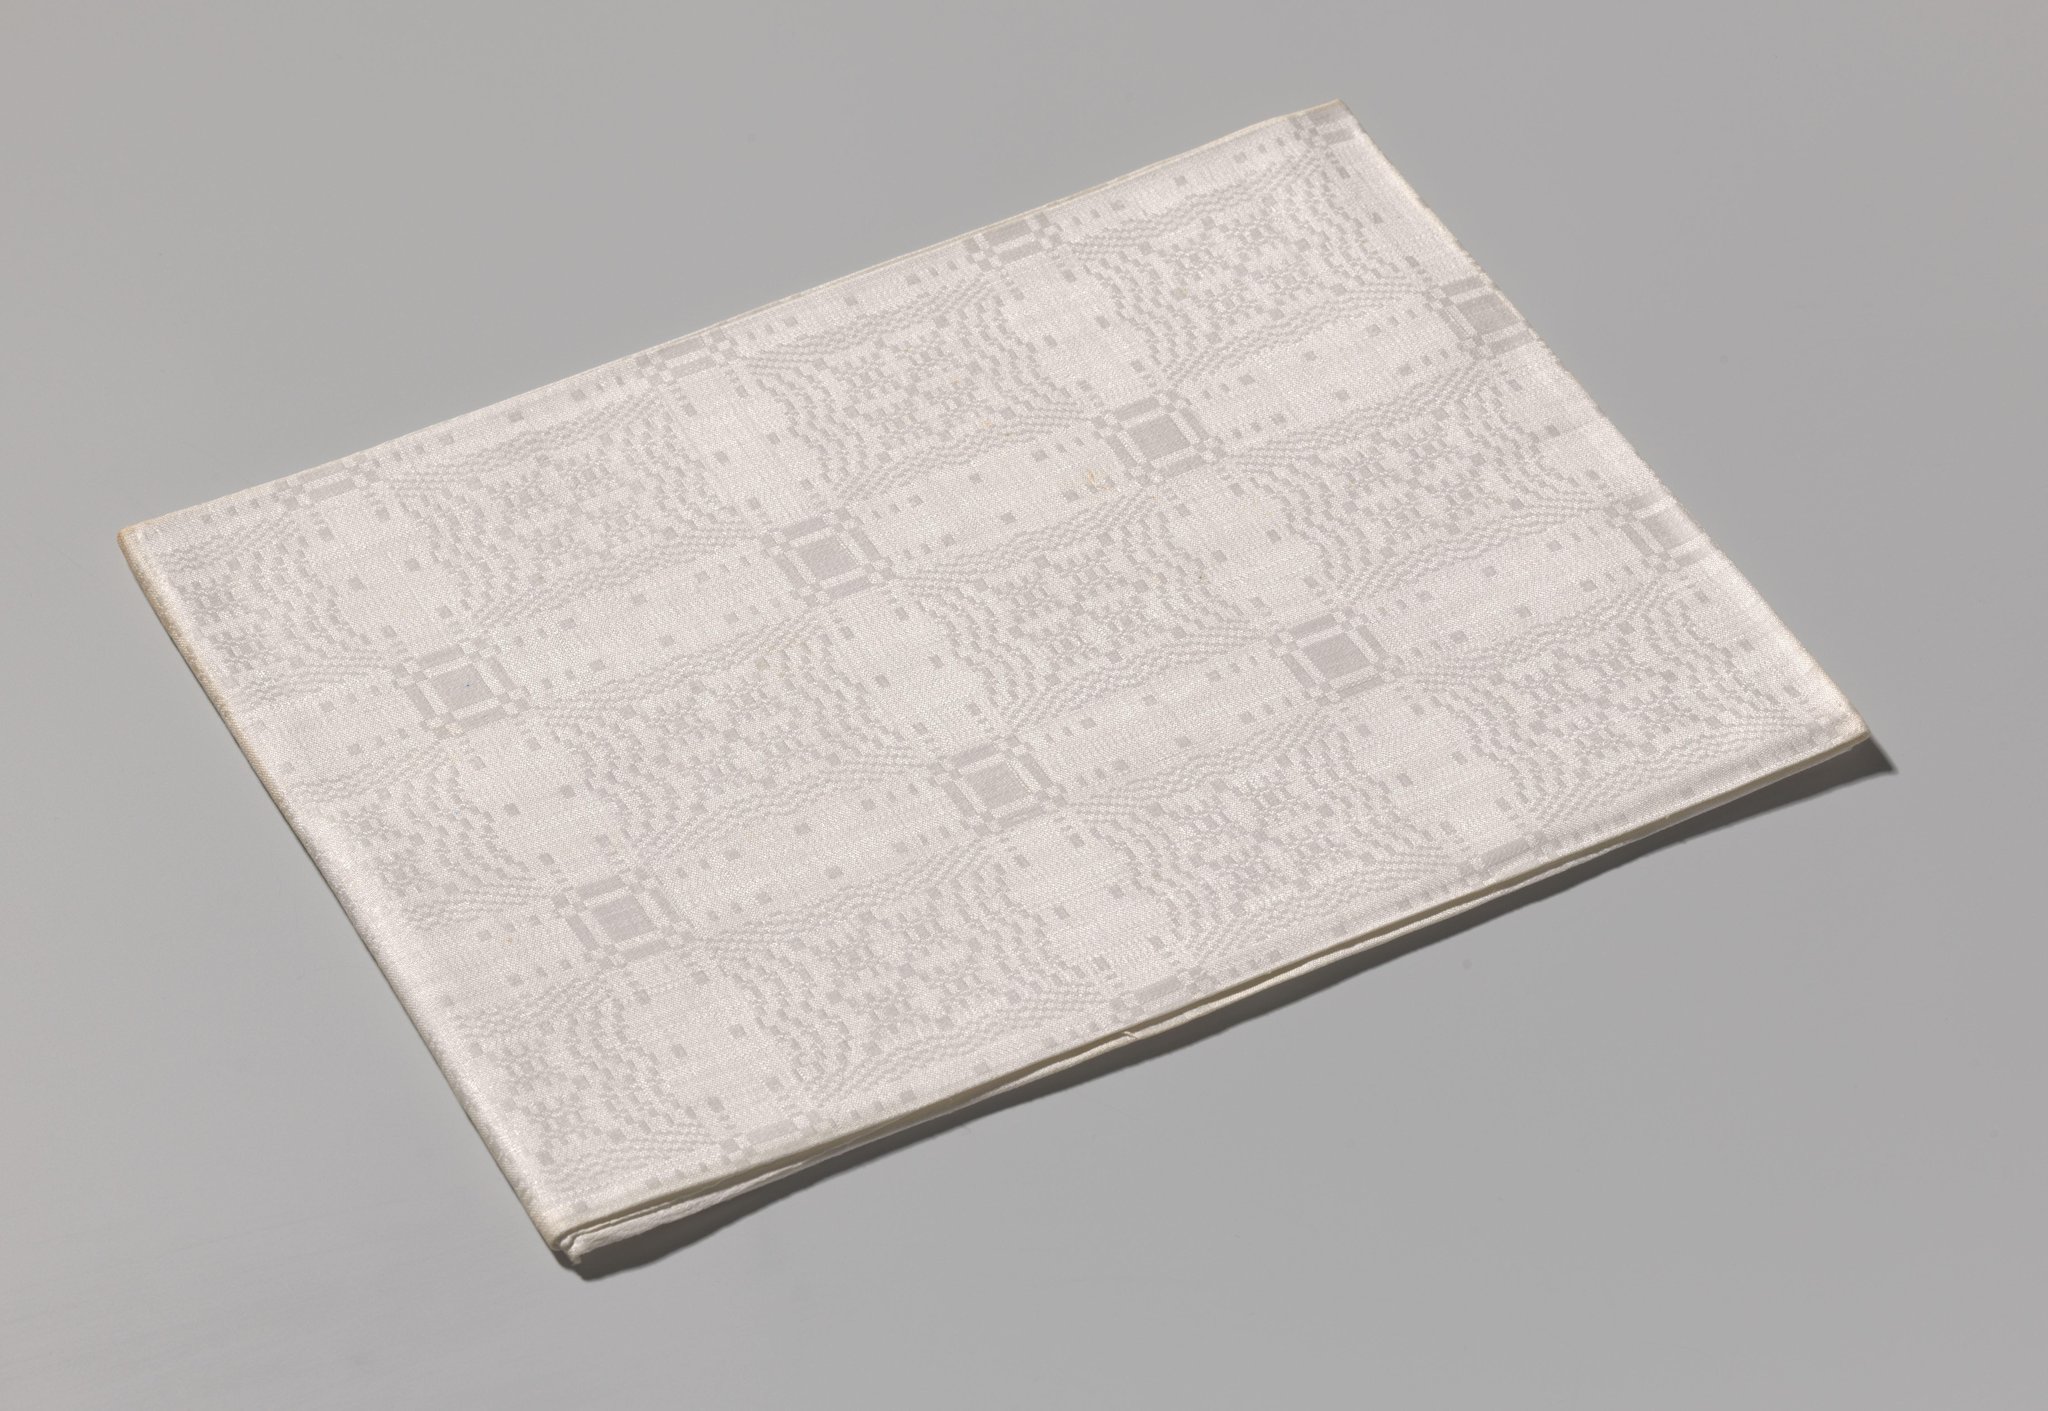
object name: napkin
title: Servet van linnen met pellenpatroon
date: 1400-1950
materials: linen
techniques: peeled fabric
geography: northern netherlands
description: Wit linnendamasten servet met pellenpatroon, merk kroon IS en 96.